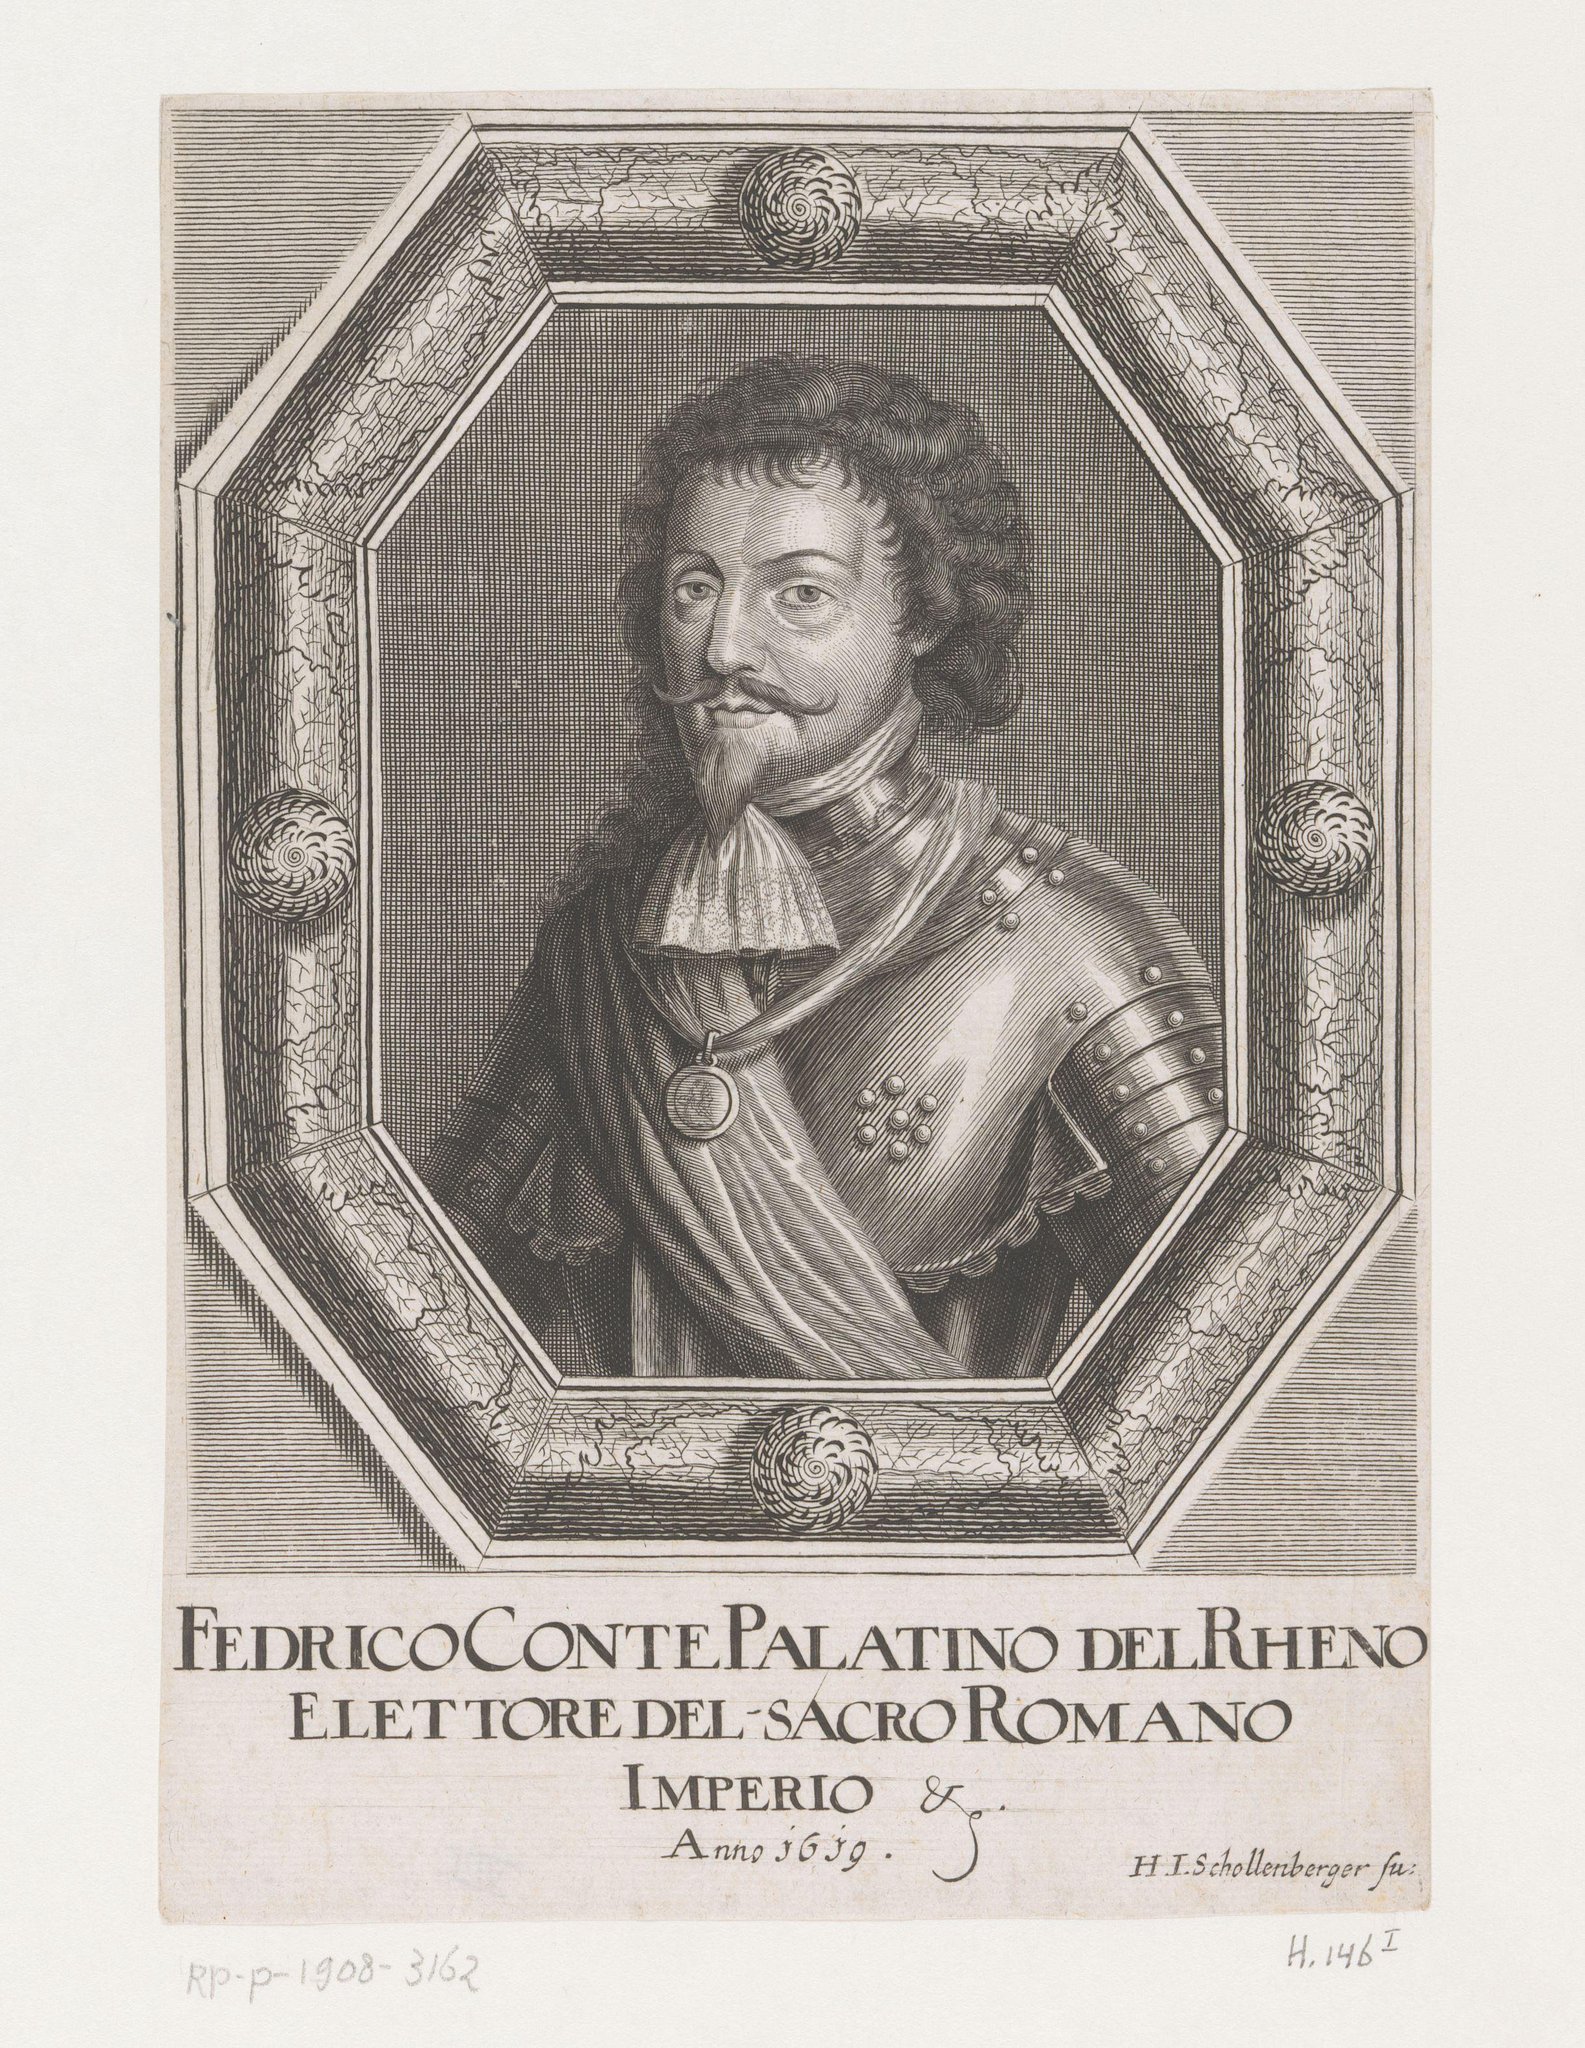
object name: print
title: Portret van Frederik V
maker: johann jacob schollenberger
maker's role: print maker, publisher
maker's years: 1646-1689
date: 1659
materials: paper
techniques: engraving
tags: amberg, frederik v (keurvorst van de palts, koning van bohemen), historical persons, king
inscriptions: collector's mark: Lugt 2228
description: Prent ook gebruikt in: Priorato, Galeazzo Gualdo. Historia di Ferdinando Terzo Imperatore, Descritta dal Conte (...). Wenen: Matthäus Cosmerovius, 1672.